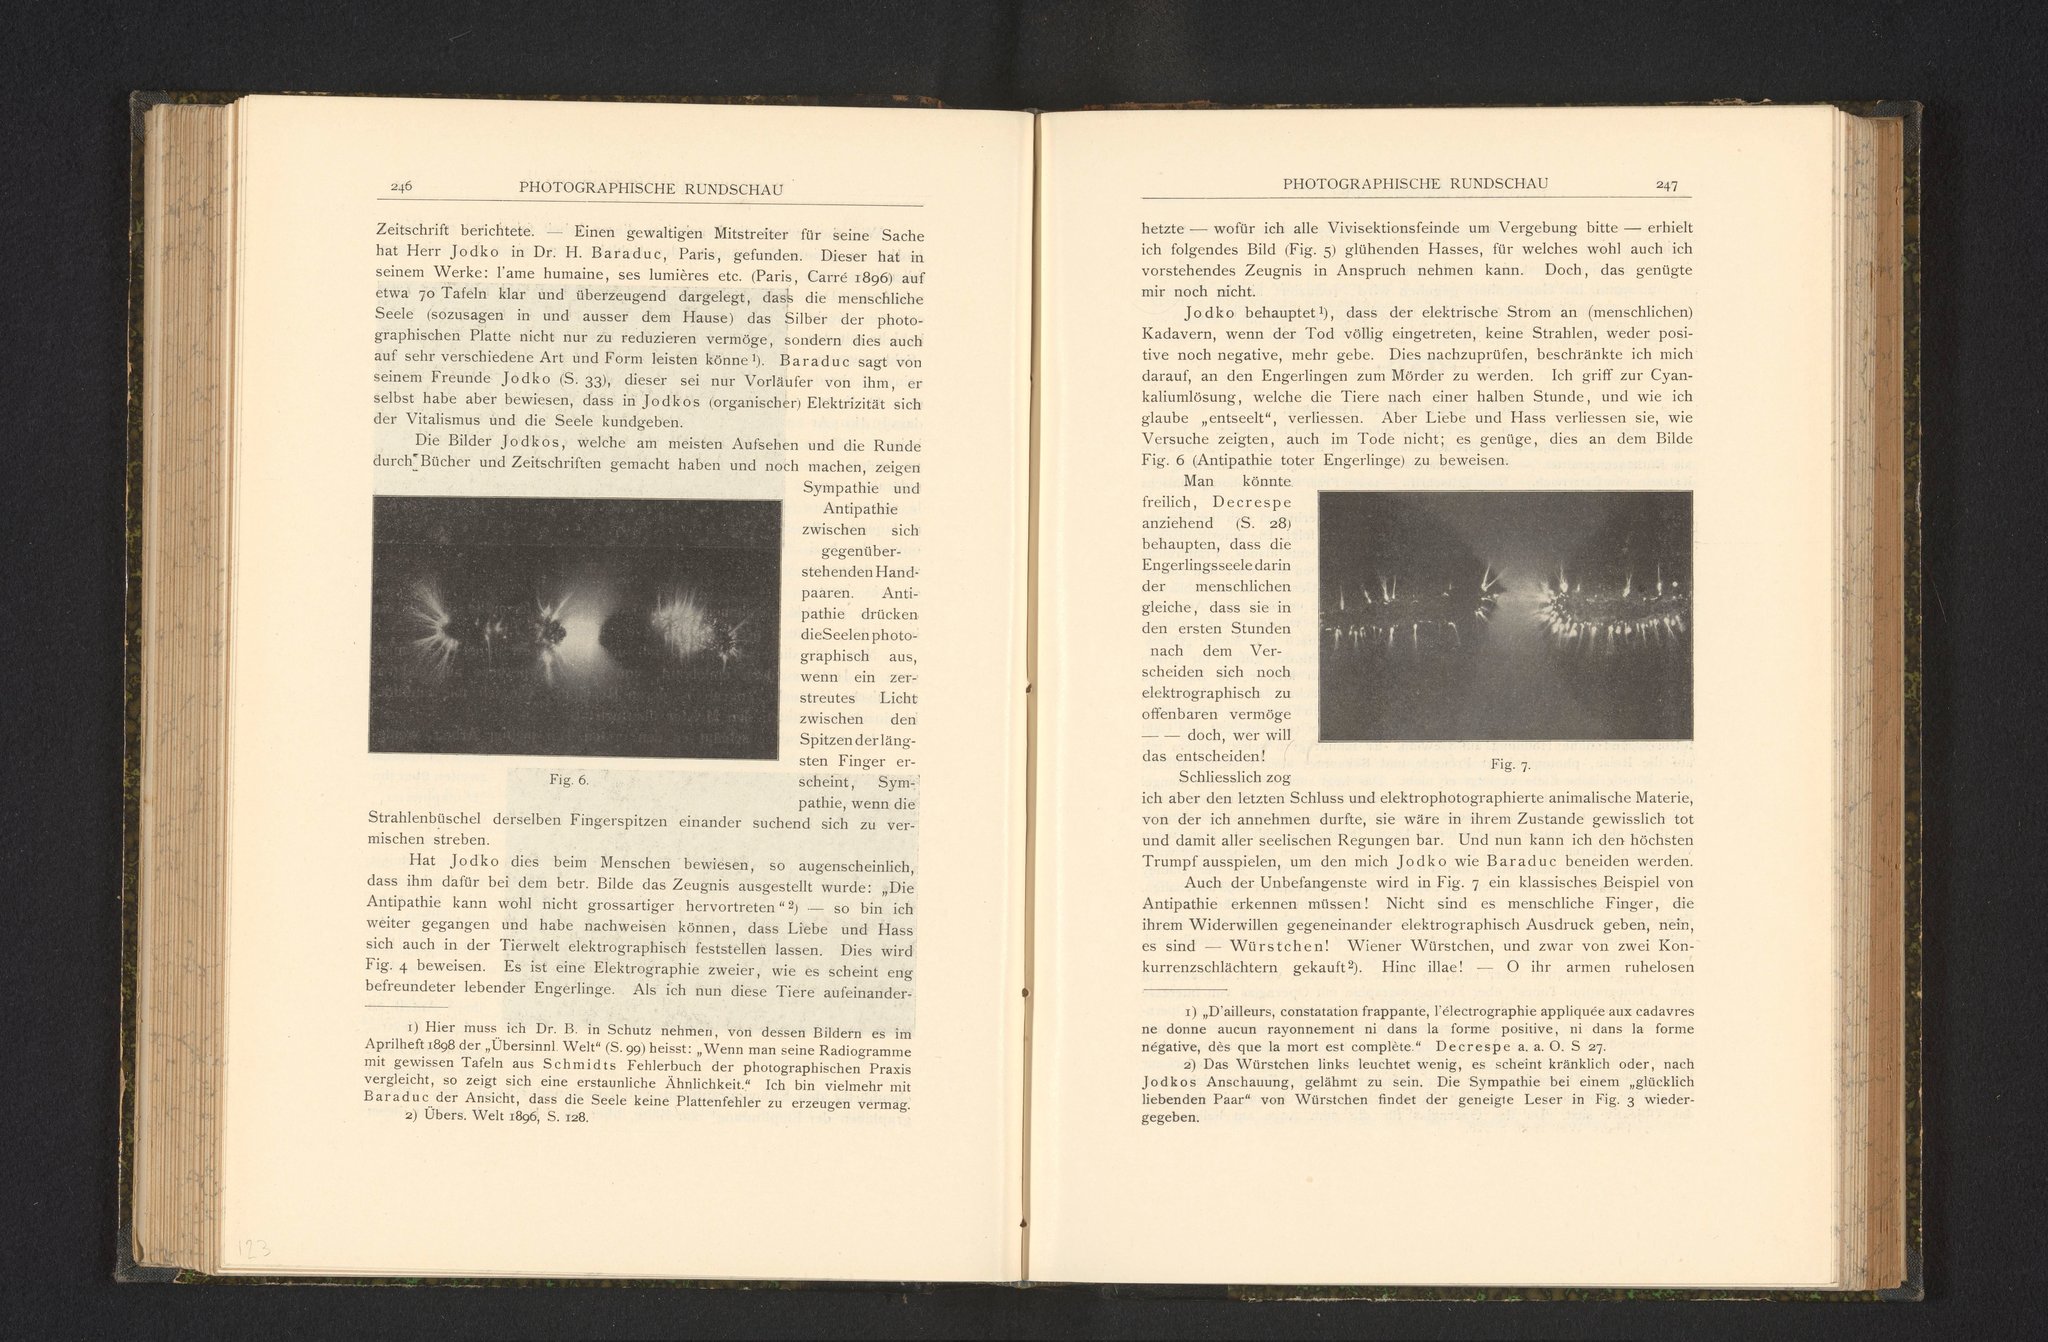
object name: page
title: Weergave van het proces van het maken van een elektrografie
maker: Anonymous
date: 1893-1898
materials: paper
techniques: autotype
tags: light, electrical phenomena